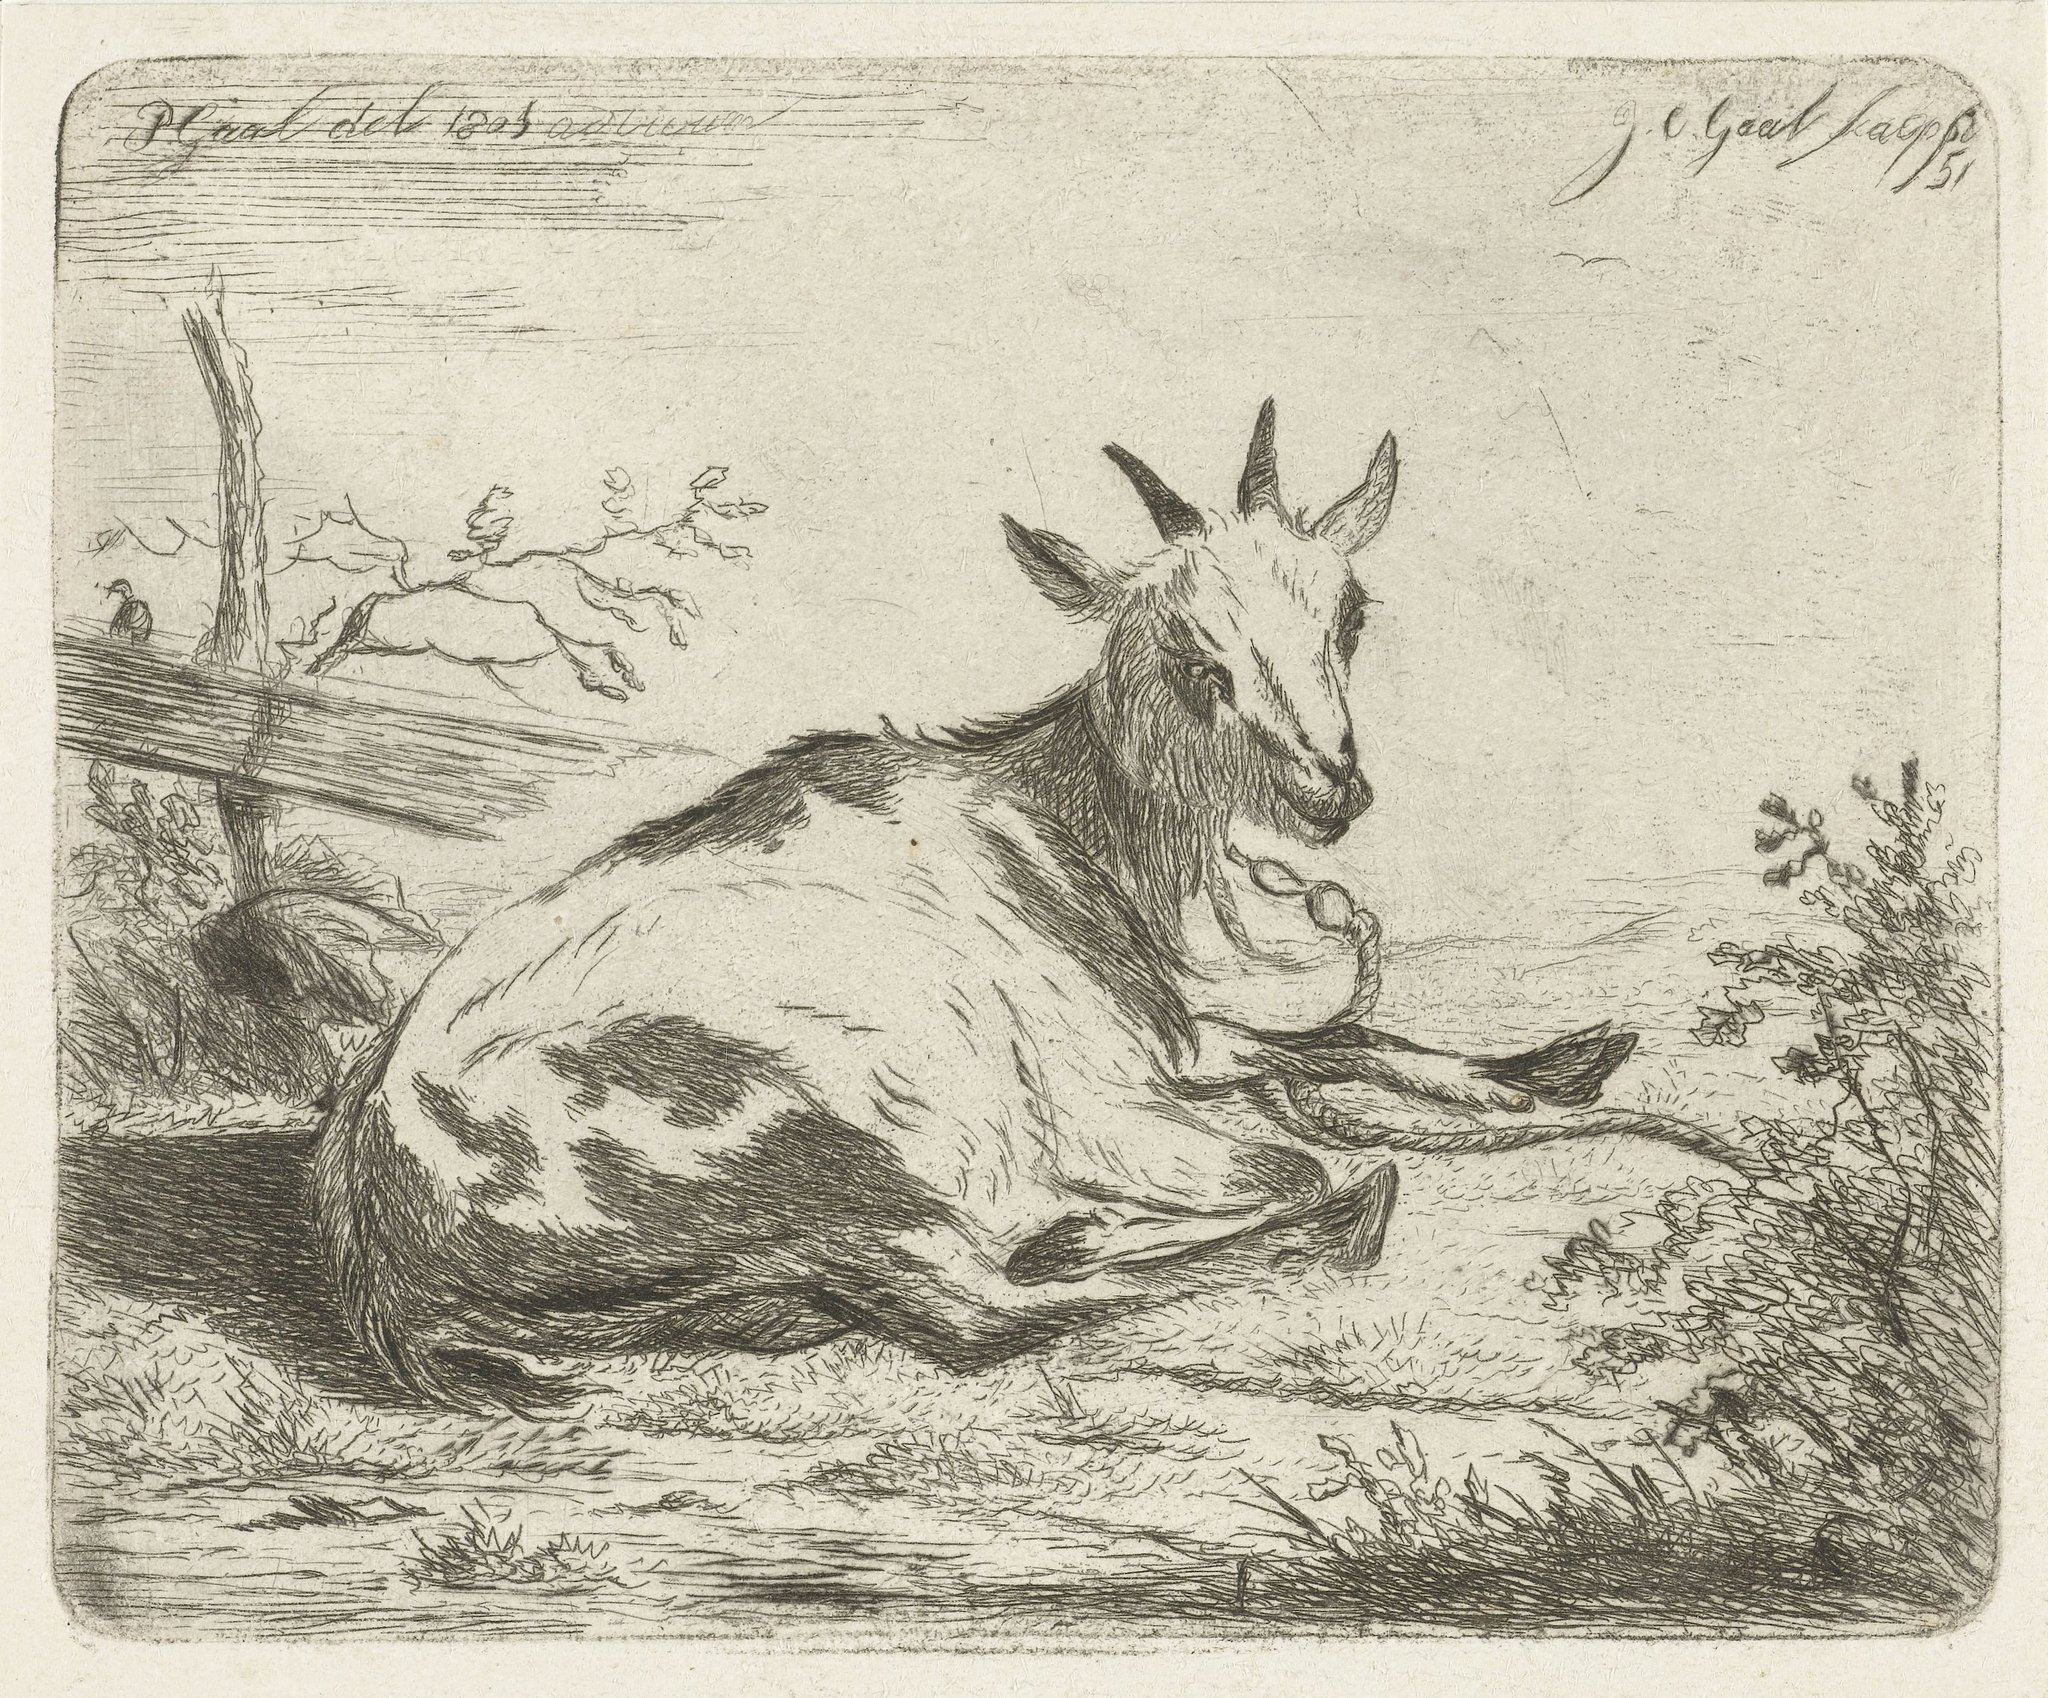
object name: print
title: Liggende geit, naar rechts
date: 1851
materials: paper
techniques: etching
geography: netherlands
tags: goat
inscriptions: collector's mark: Lugt 2228